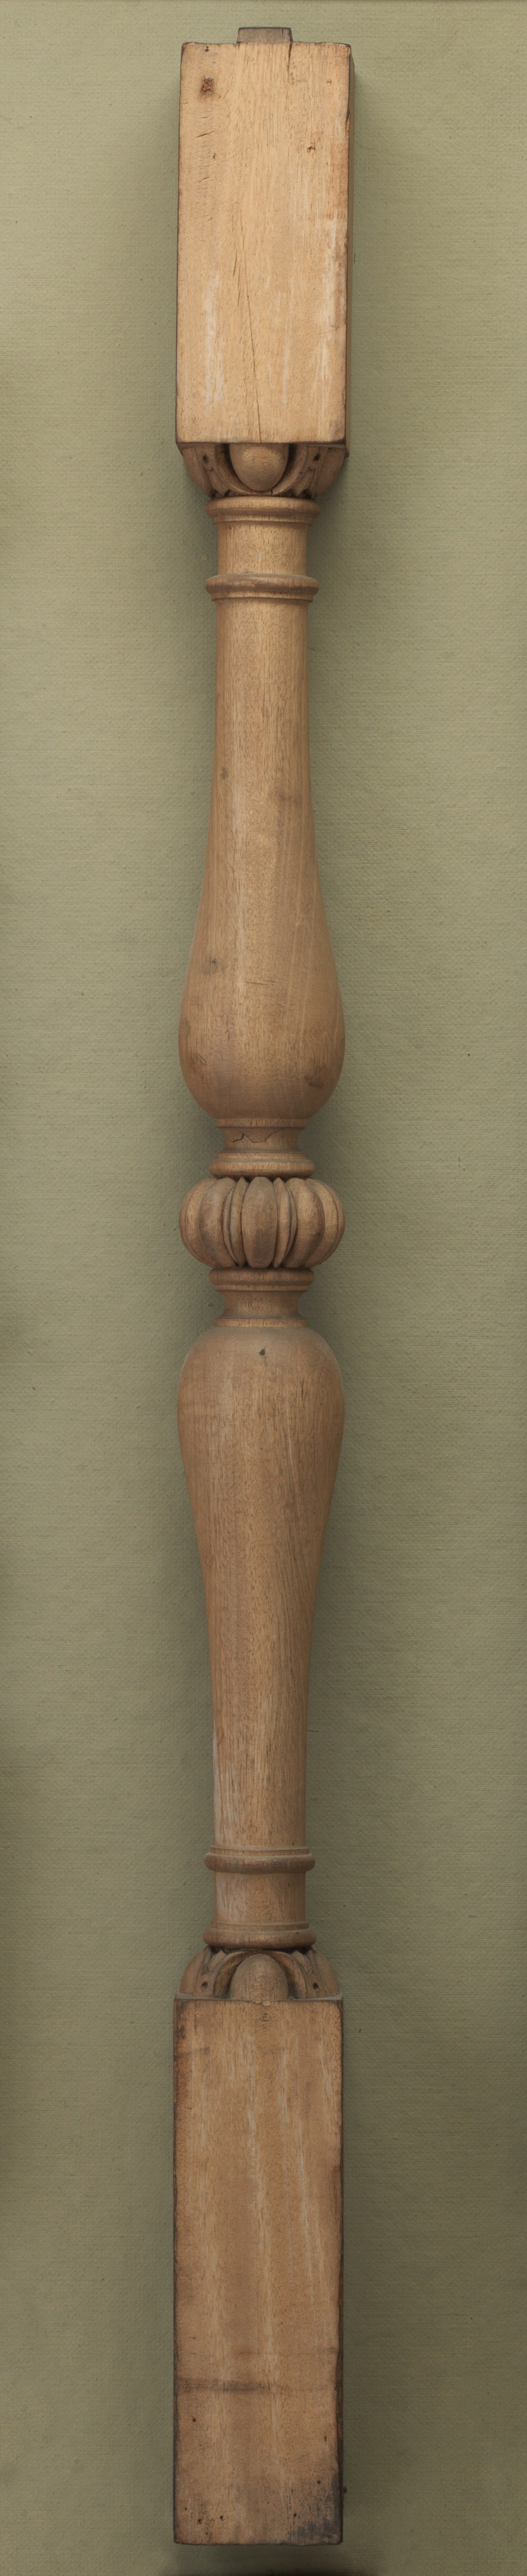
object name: baluster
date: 1601-1650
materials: wood